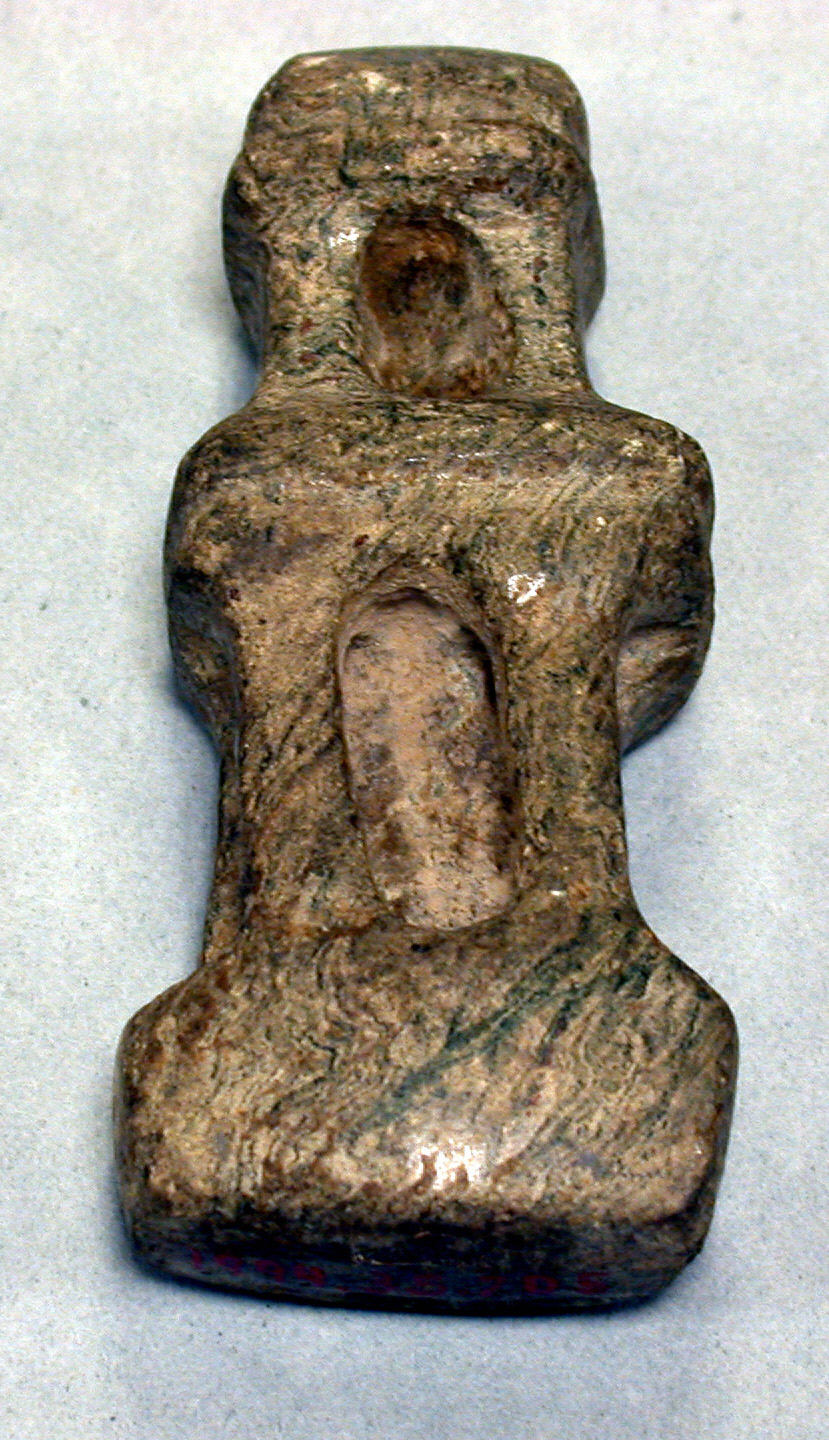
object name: architectural model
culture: mezcala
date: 1-800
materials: stone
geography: mexico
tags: temples